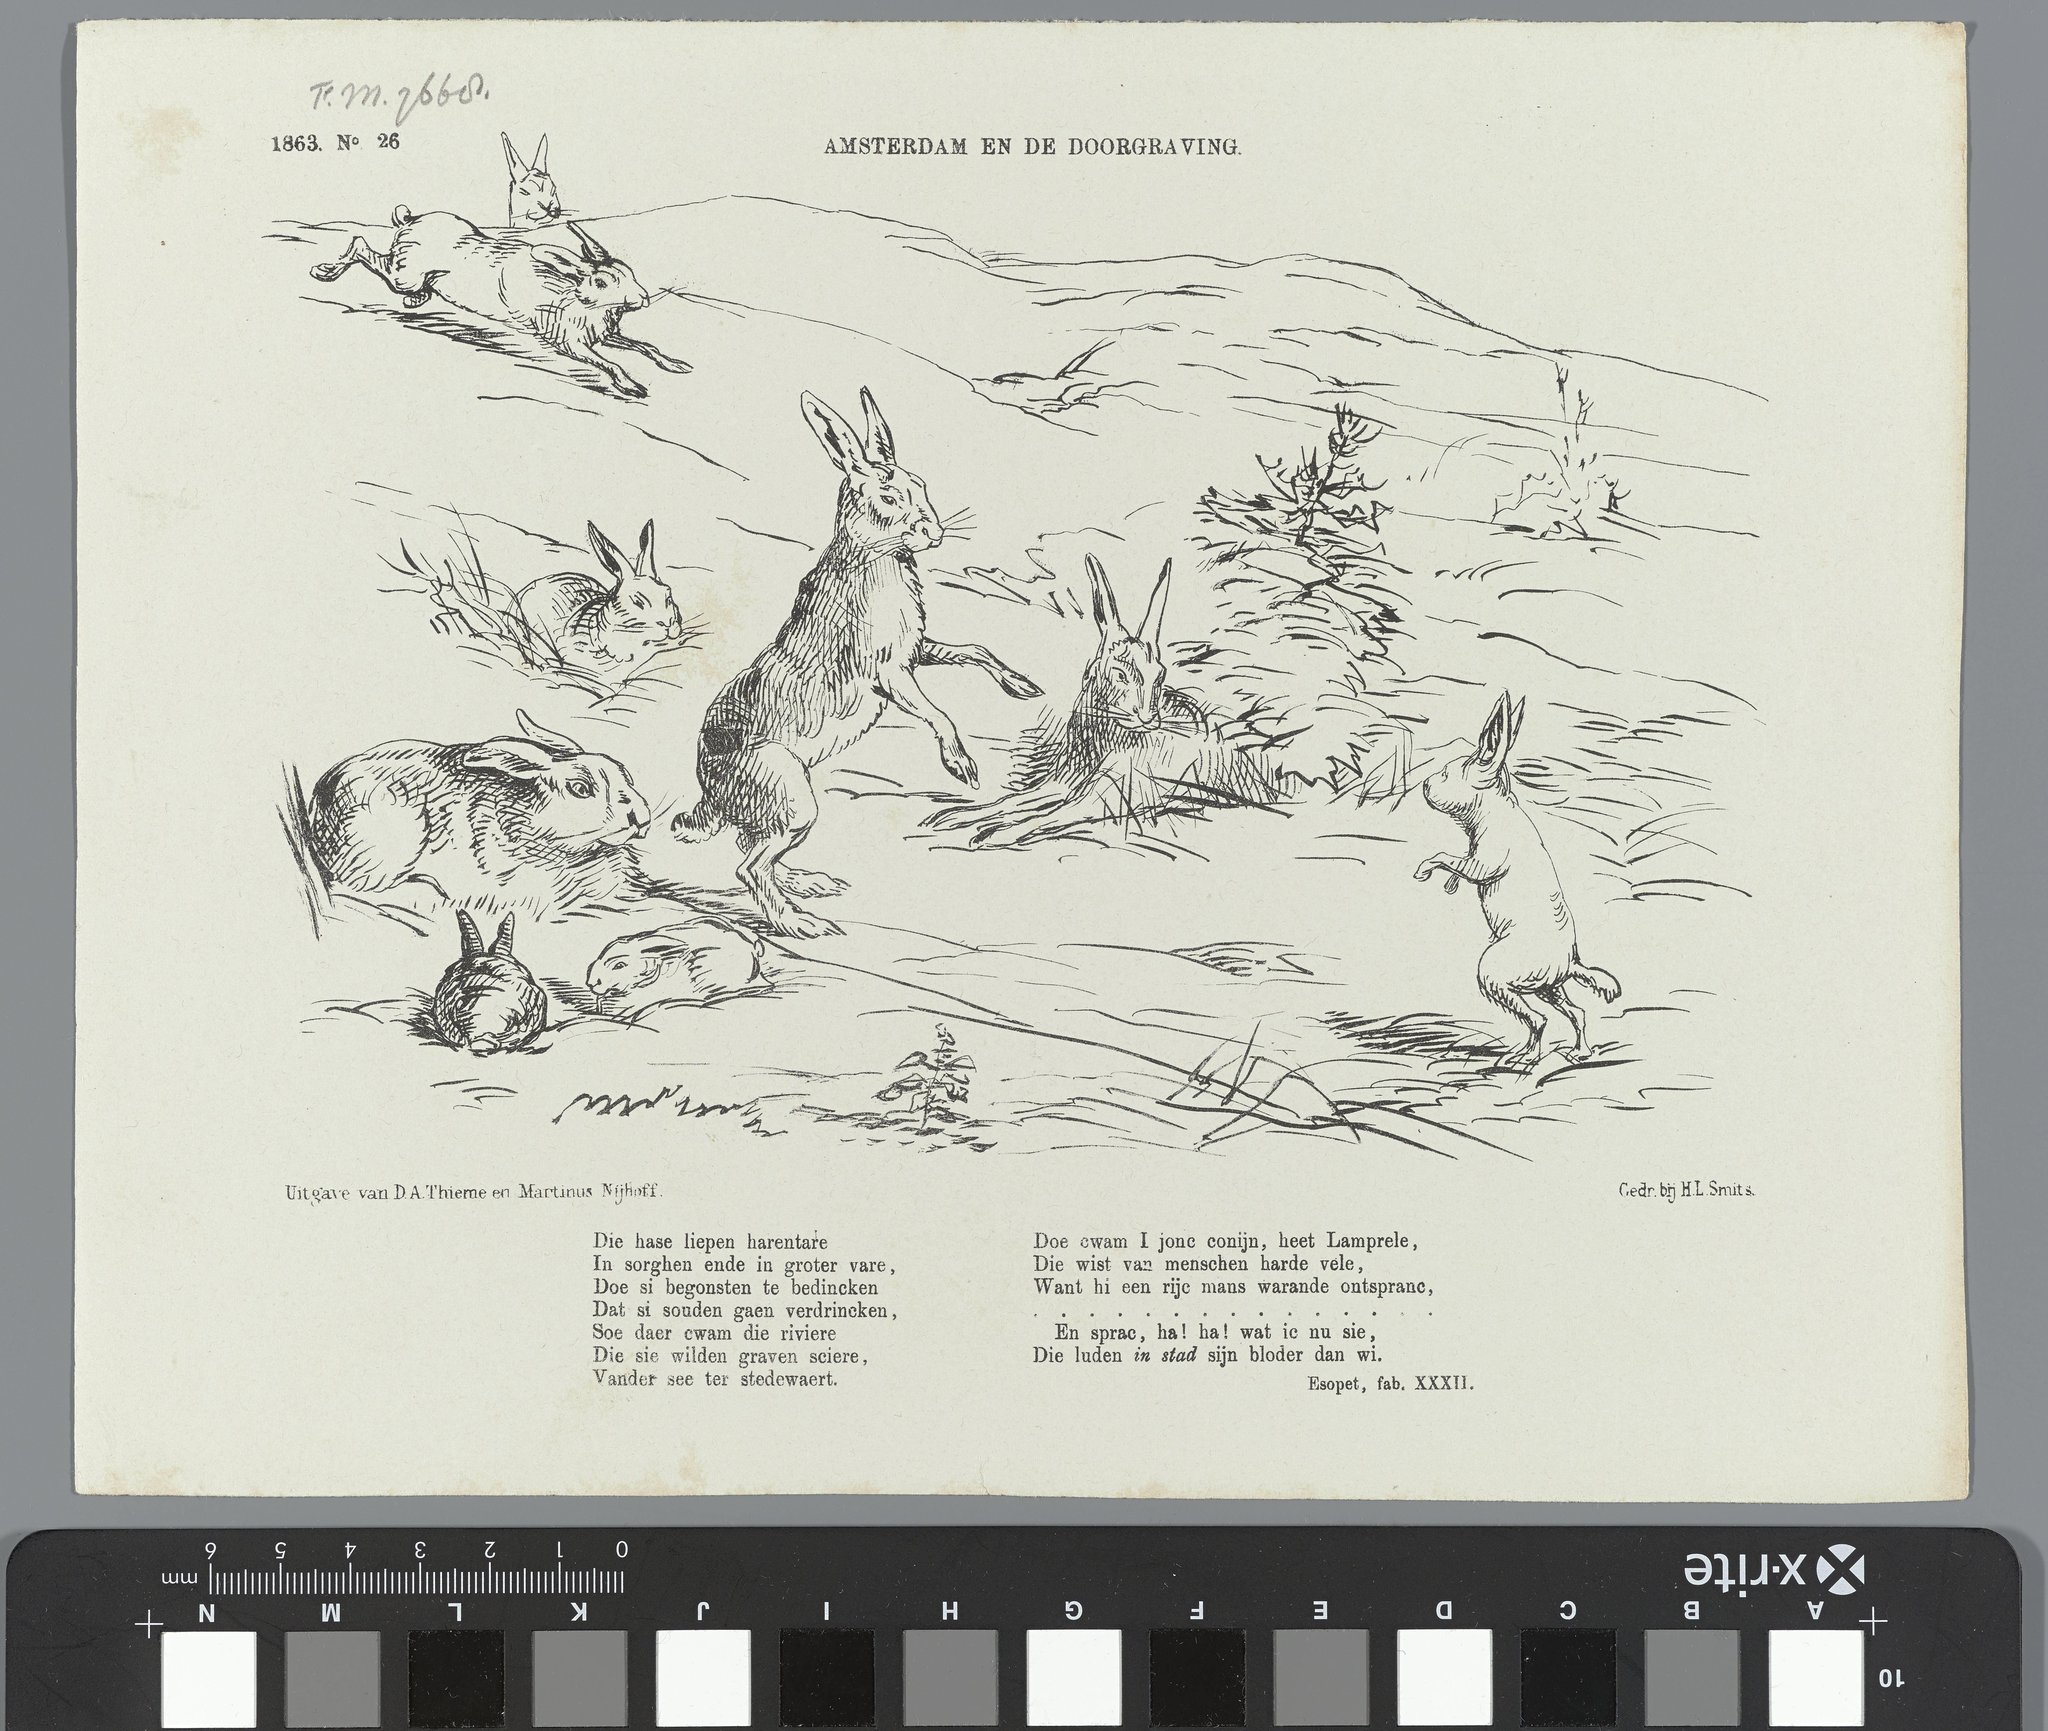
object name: cartoon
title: Amsterdam en de doorgraving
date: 1863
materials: paper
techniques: lithograph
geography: arnhem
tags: rodents: rabbit, amsterdam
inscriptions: collector's mark: Lugt 2228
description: Spotprent op de angst die in Amsterdam bestond rond de doorgraving van Holland op zijn smalst. Landschap met konijnen en konijnenholen. Plaat verschenen bij het weekblad De Nederlandsche Spectator, nr. 26, 27 juni 1863.